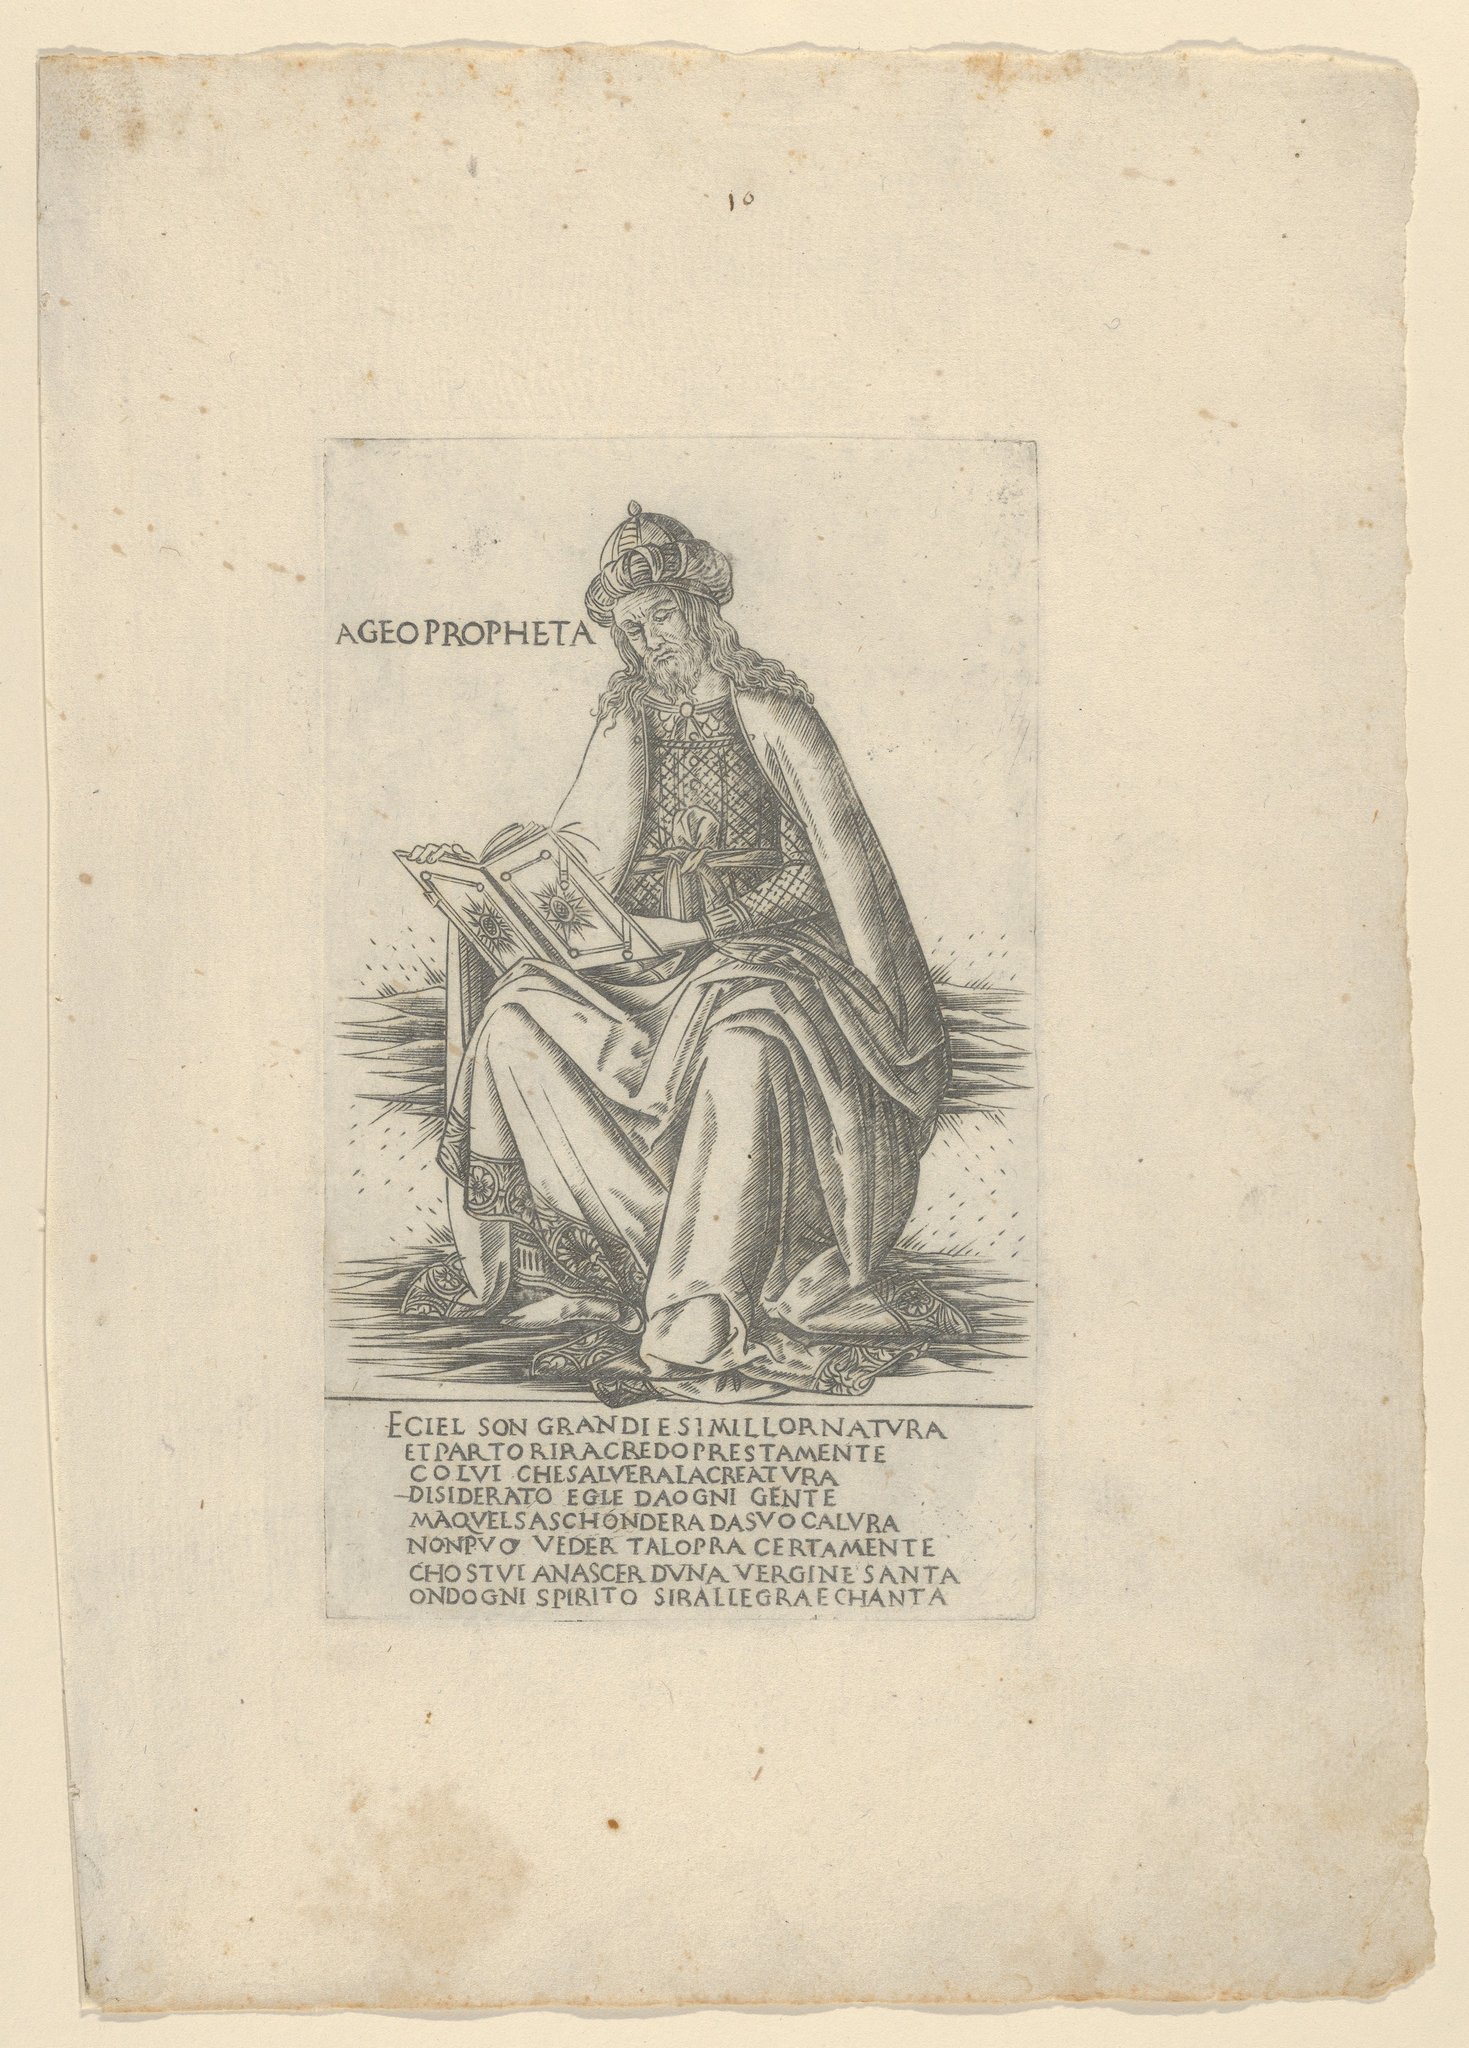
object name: print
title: The Prophet Haggai, from Prophets and Sibyls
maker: francesco rosselli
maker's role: artist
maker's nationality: italian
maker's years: 1448-1527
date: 1480-1490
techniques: engraving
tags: men,reading